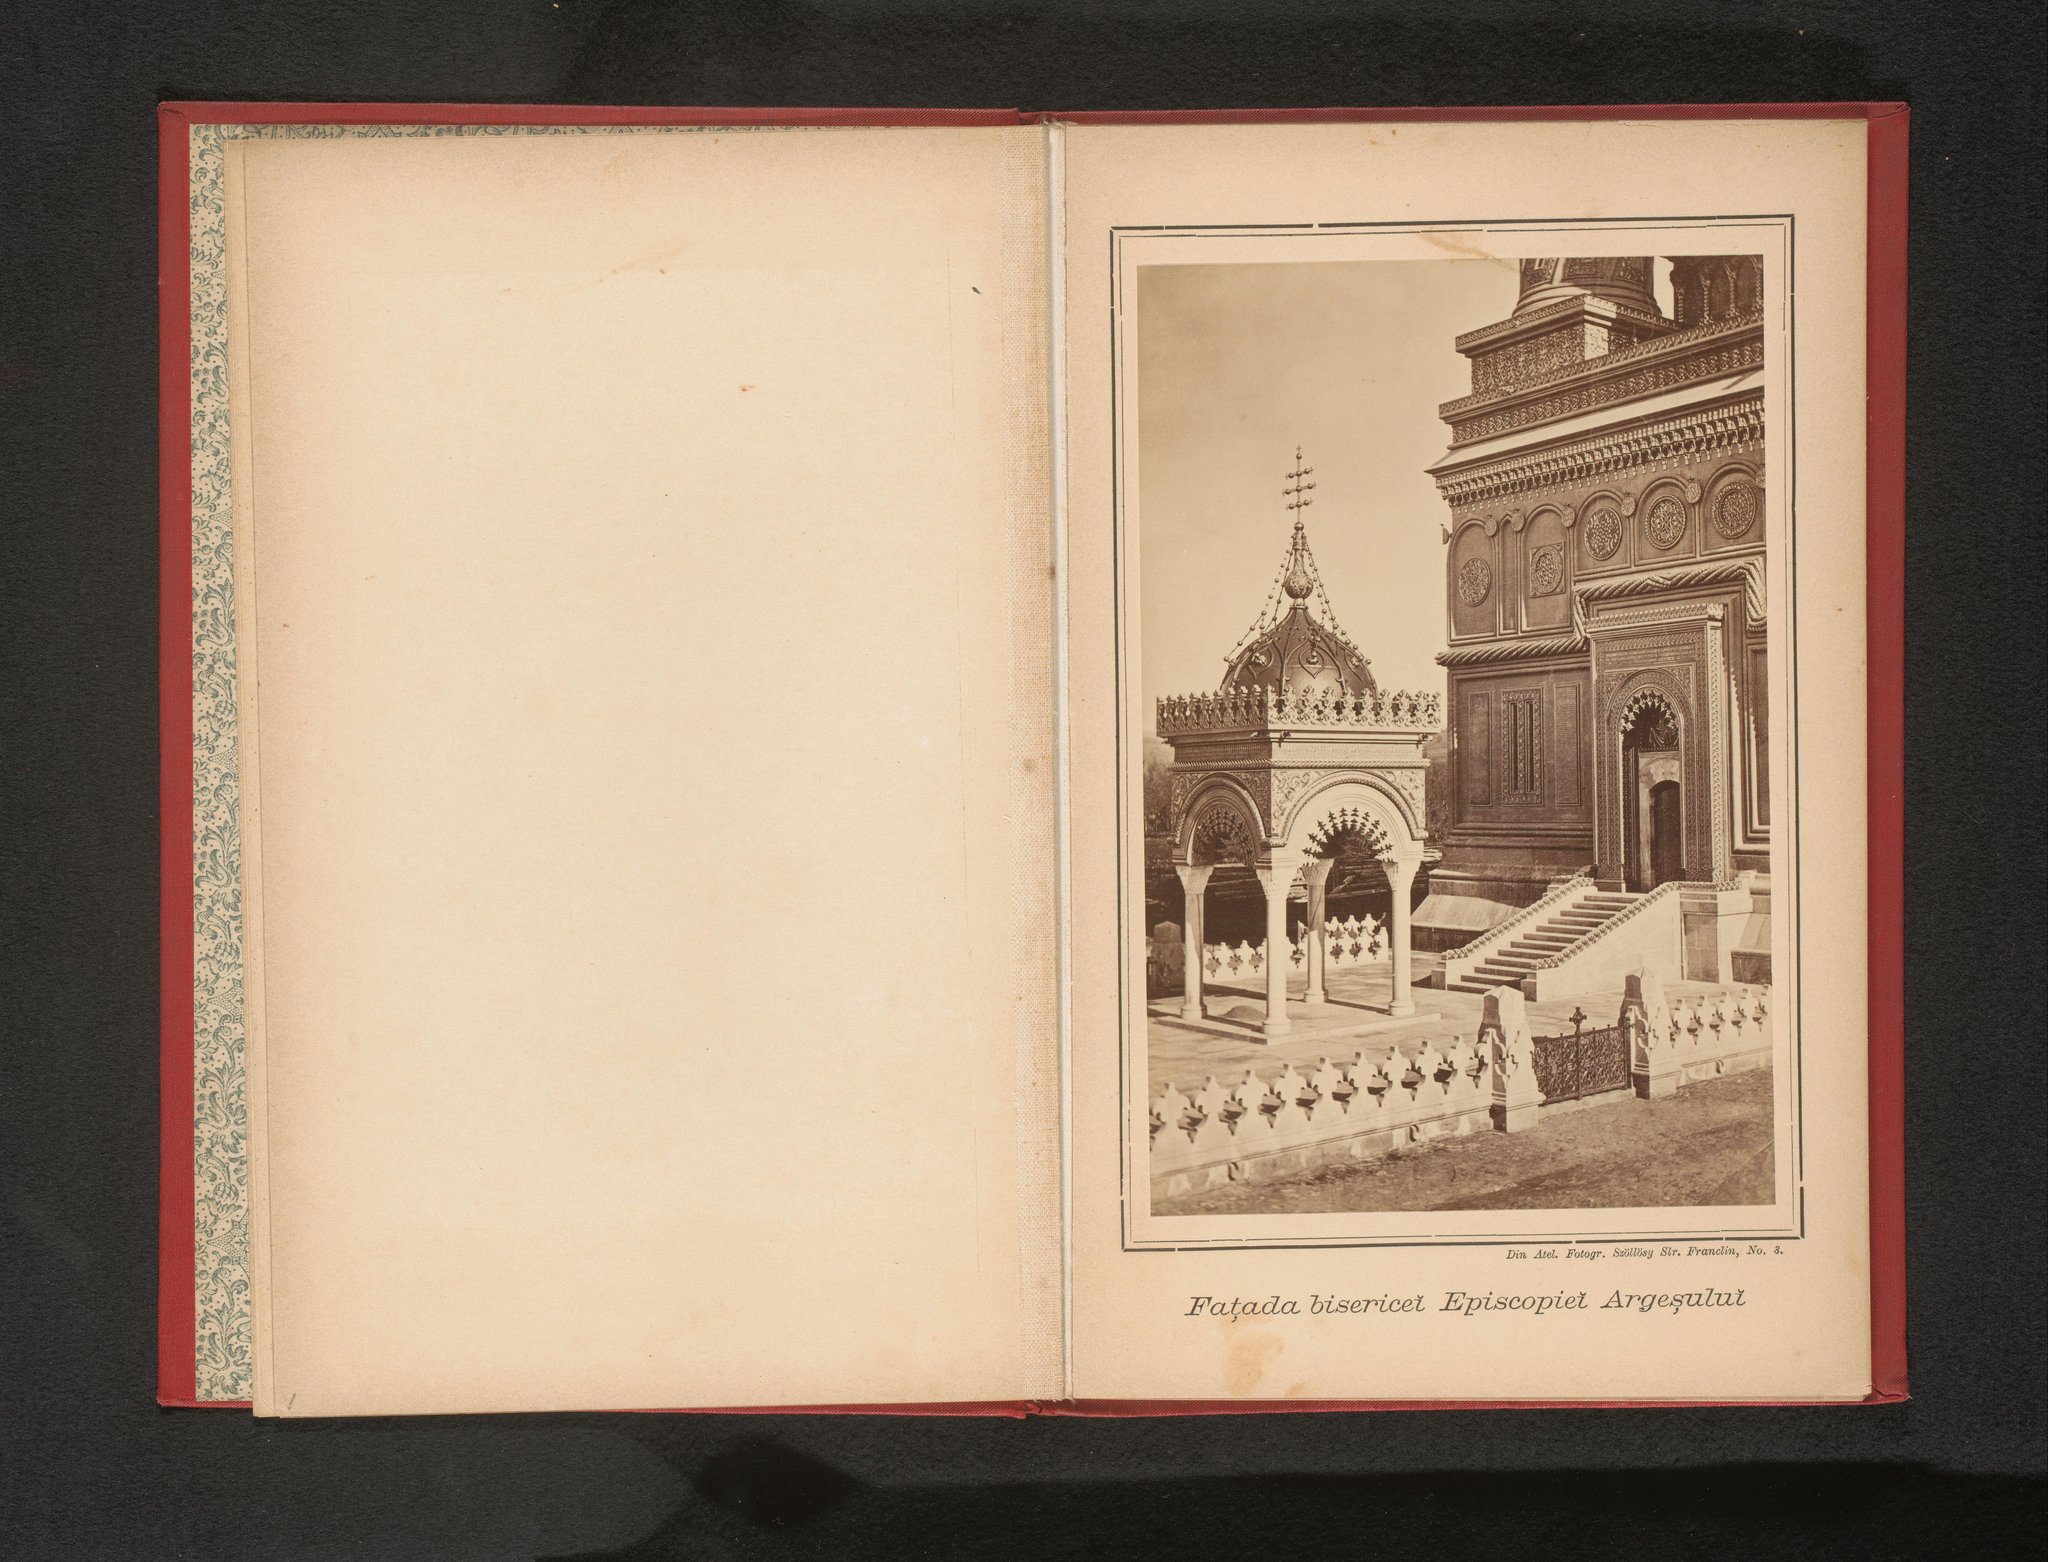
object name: page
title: Toegangsportaal van de Kathedraal van Curtea de Argeș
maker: szöllösy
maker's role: fotograaf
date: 1886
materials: photographic support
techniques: albumen print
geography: curtea de argeș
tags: parts of church exterior and annexes: portal, façade (of house or building)